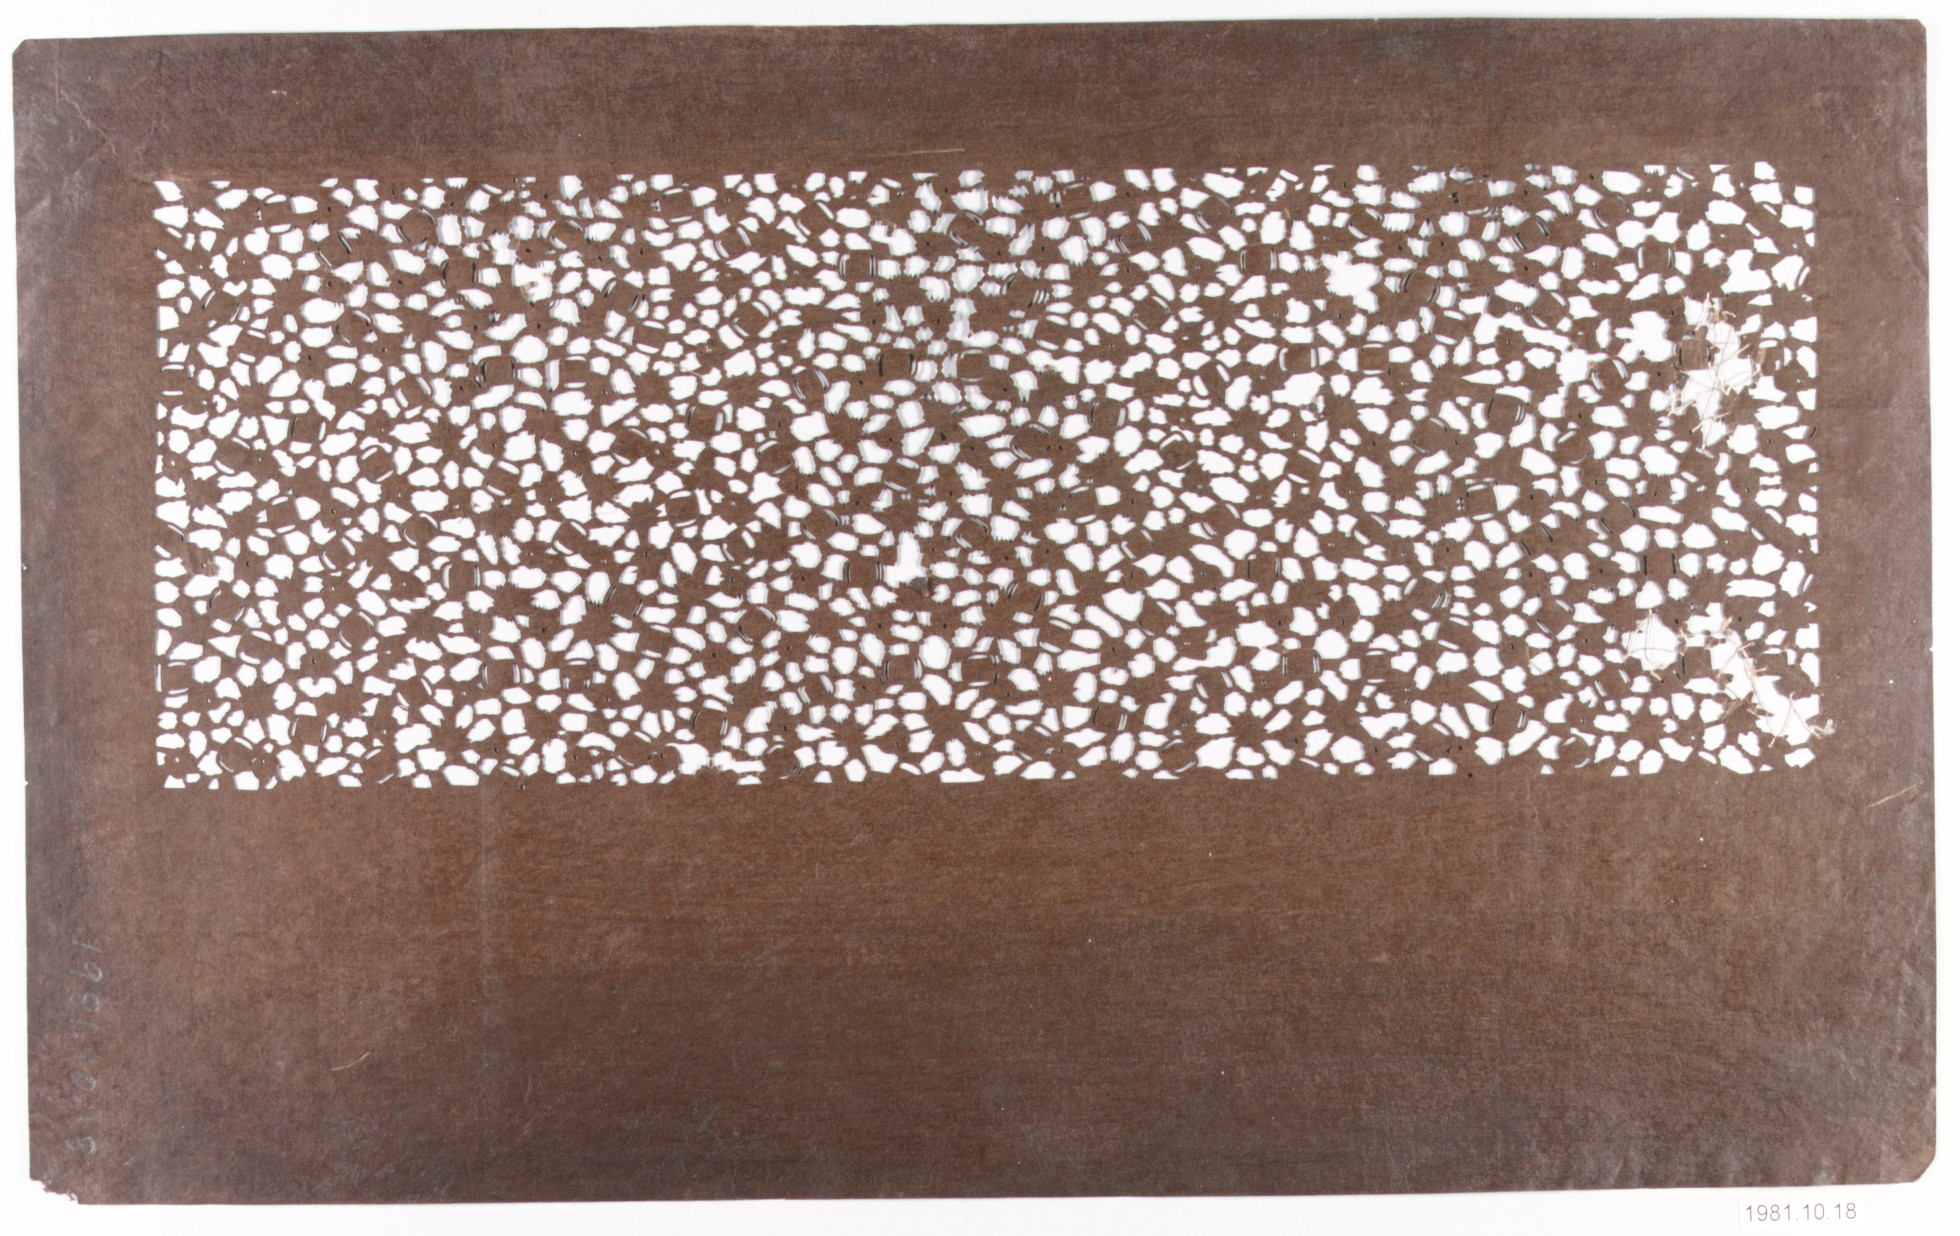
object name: stencil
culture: japanese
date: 1801-1900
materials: paper